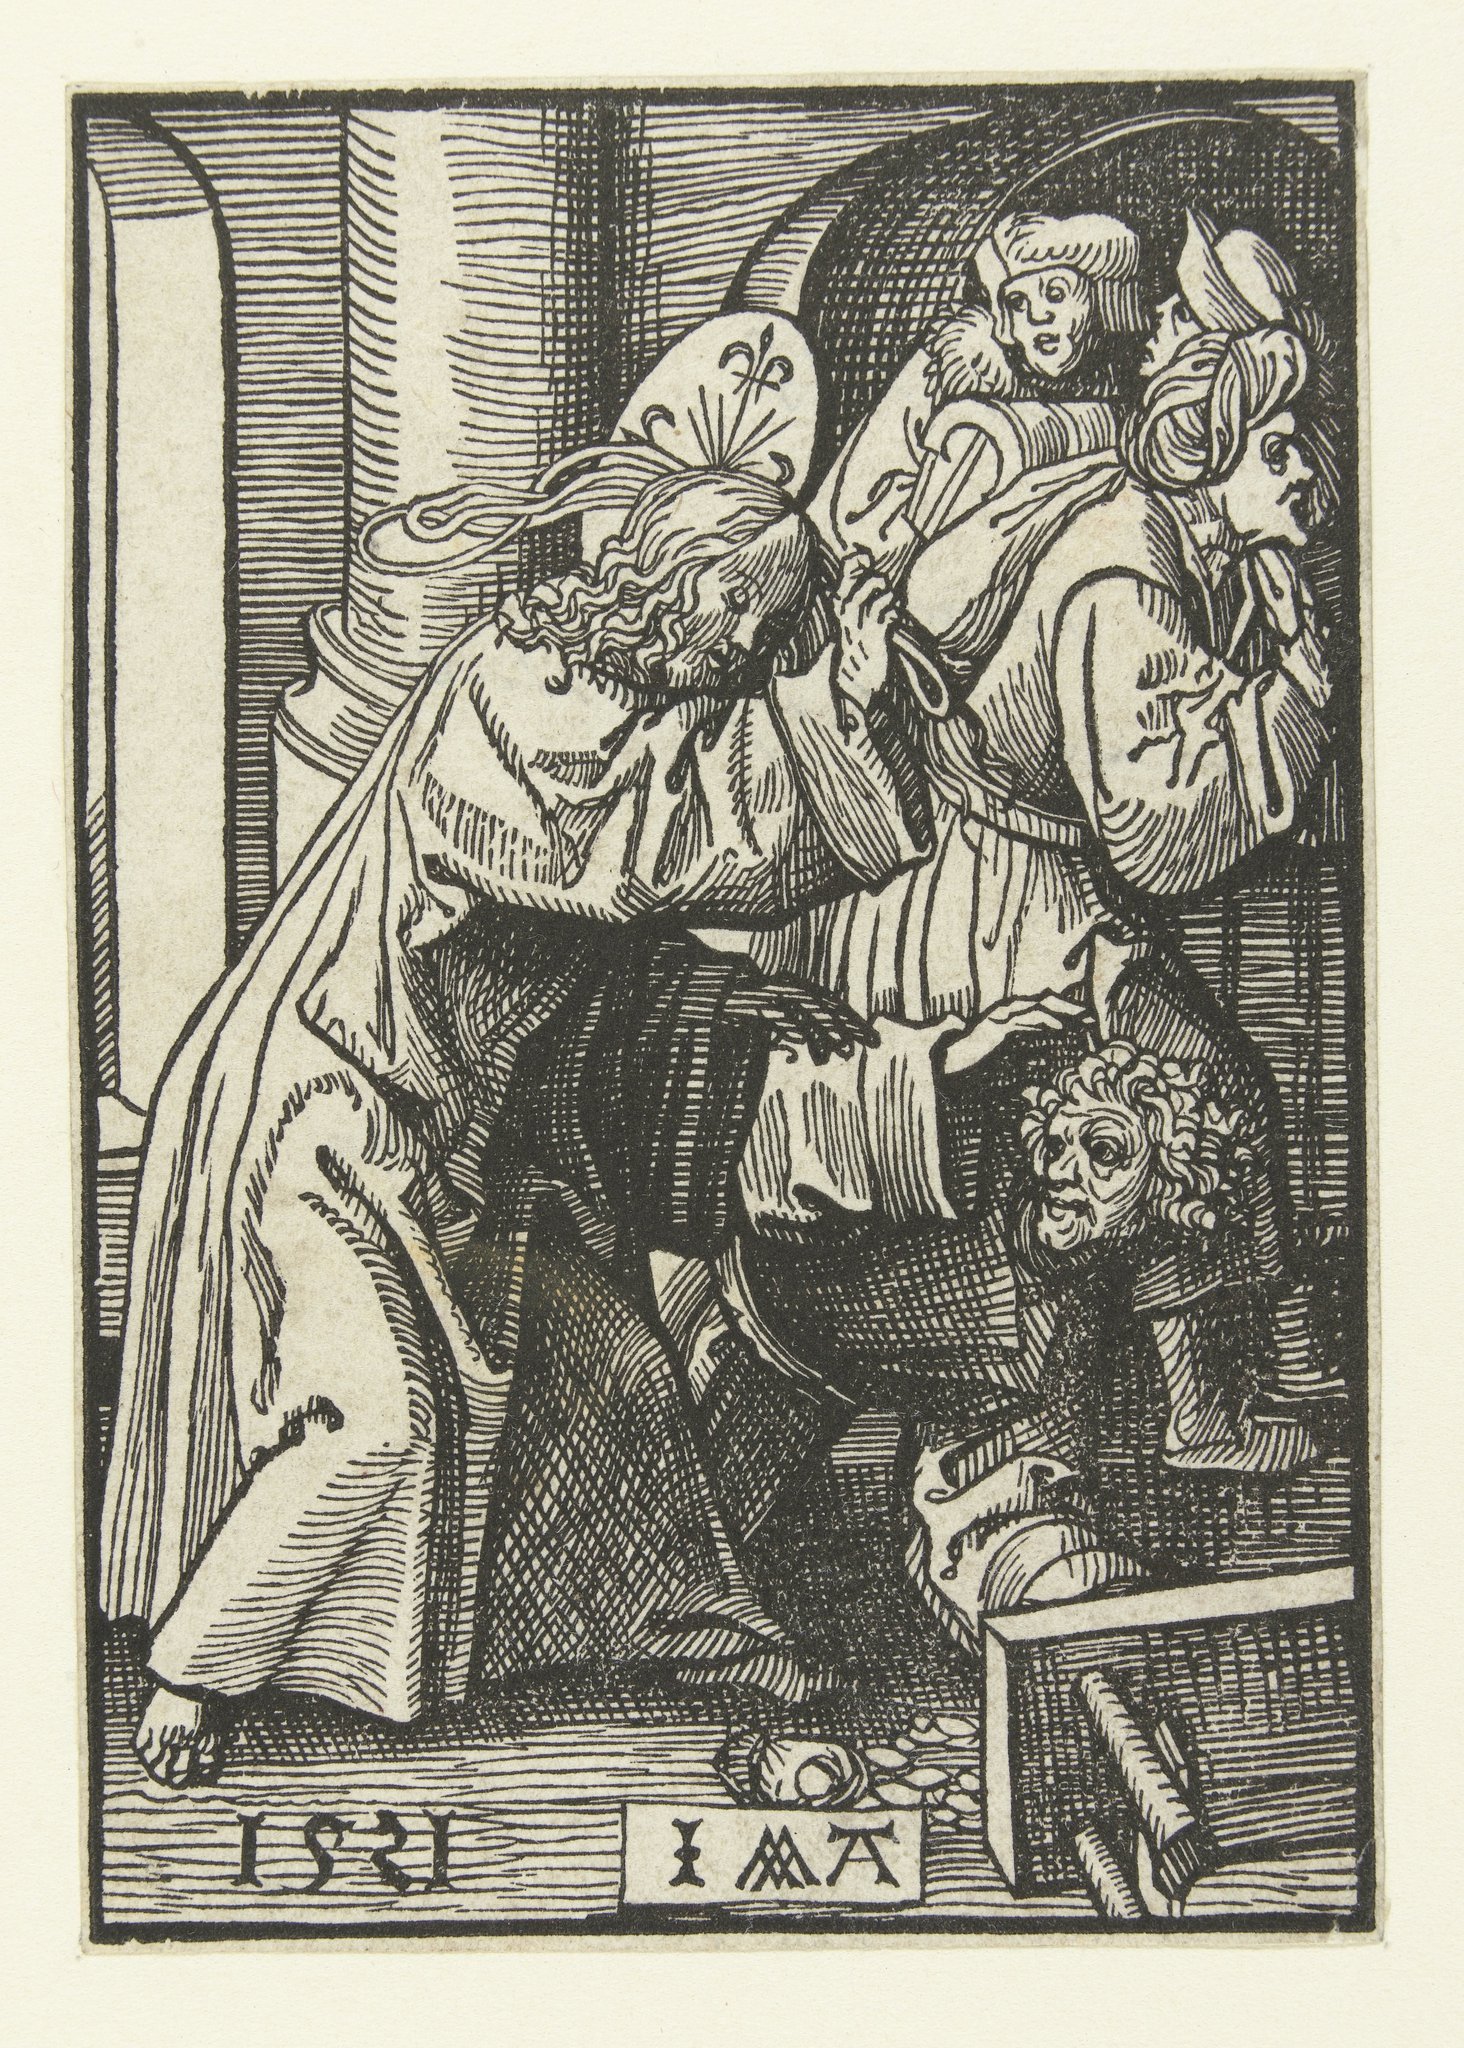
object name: print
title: De Kleine Passie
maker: jacob cornelisz van oostsanen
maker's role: draughtsman, painter, print maker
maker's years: 1475-1533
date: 1521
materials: paper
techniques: woodcut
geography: low countries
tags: purification of the temple ('first' and 'second'): christ driving the money-changers from the temple with a whip (matthew 21:12-13; mark 11:15-17; luke 19:45-46; john 12:12-19)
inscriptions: collector's mark: Lugt 240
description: Uit serie van 66 prenten. Proefdruk, geen tekst op verso.